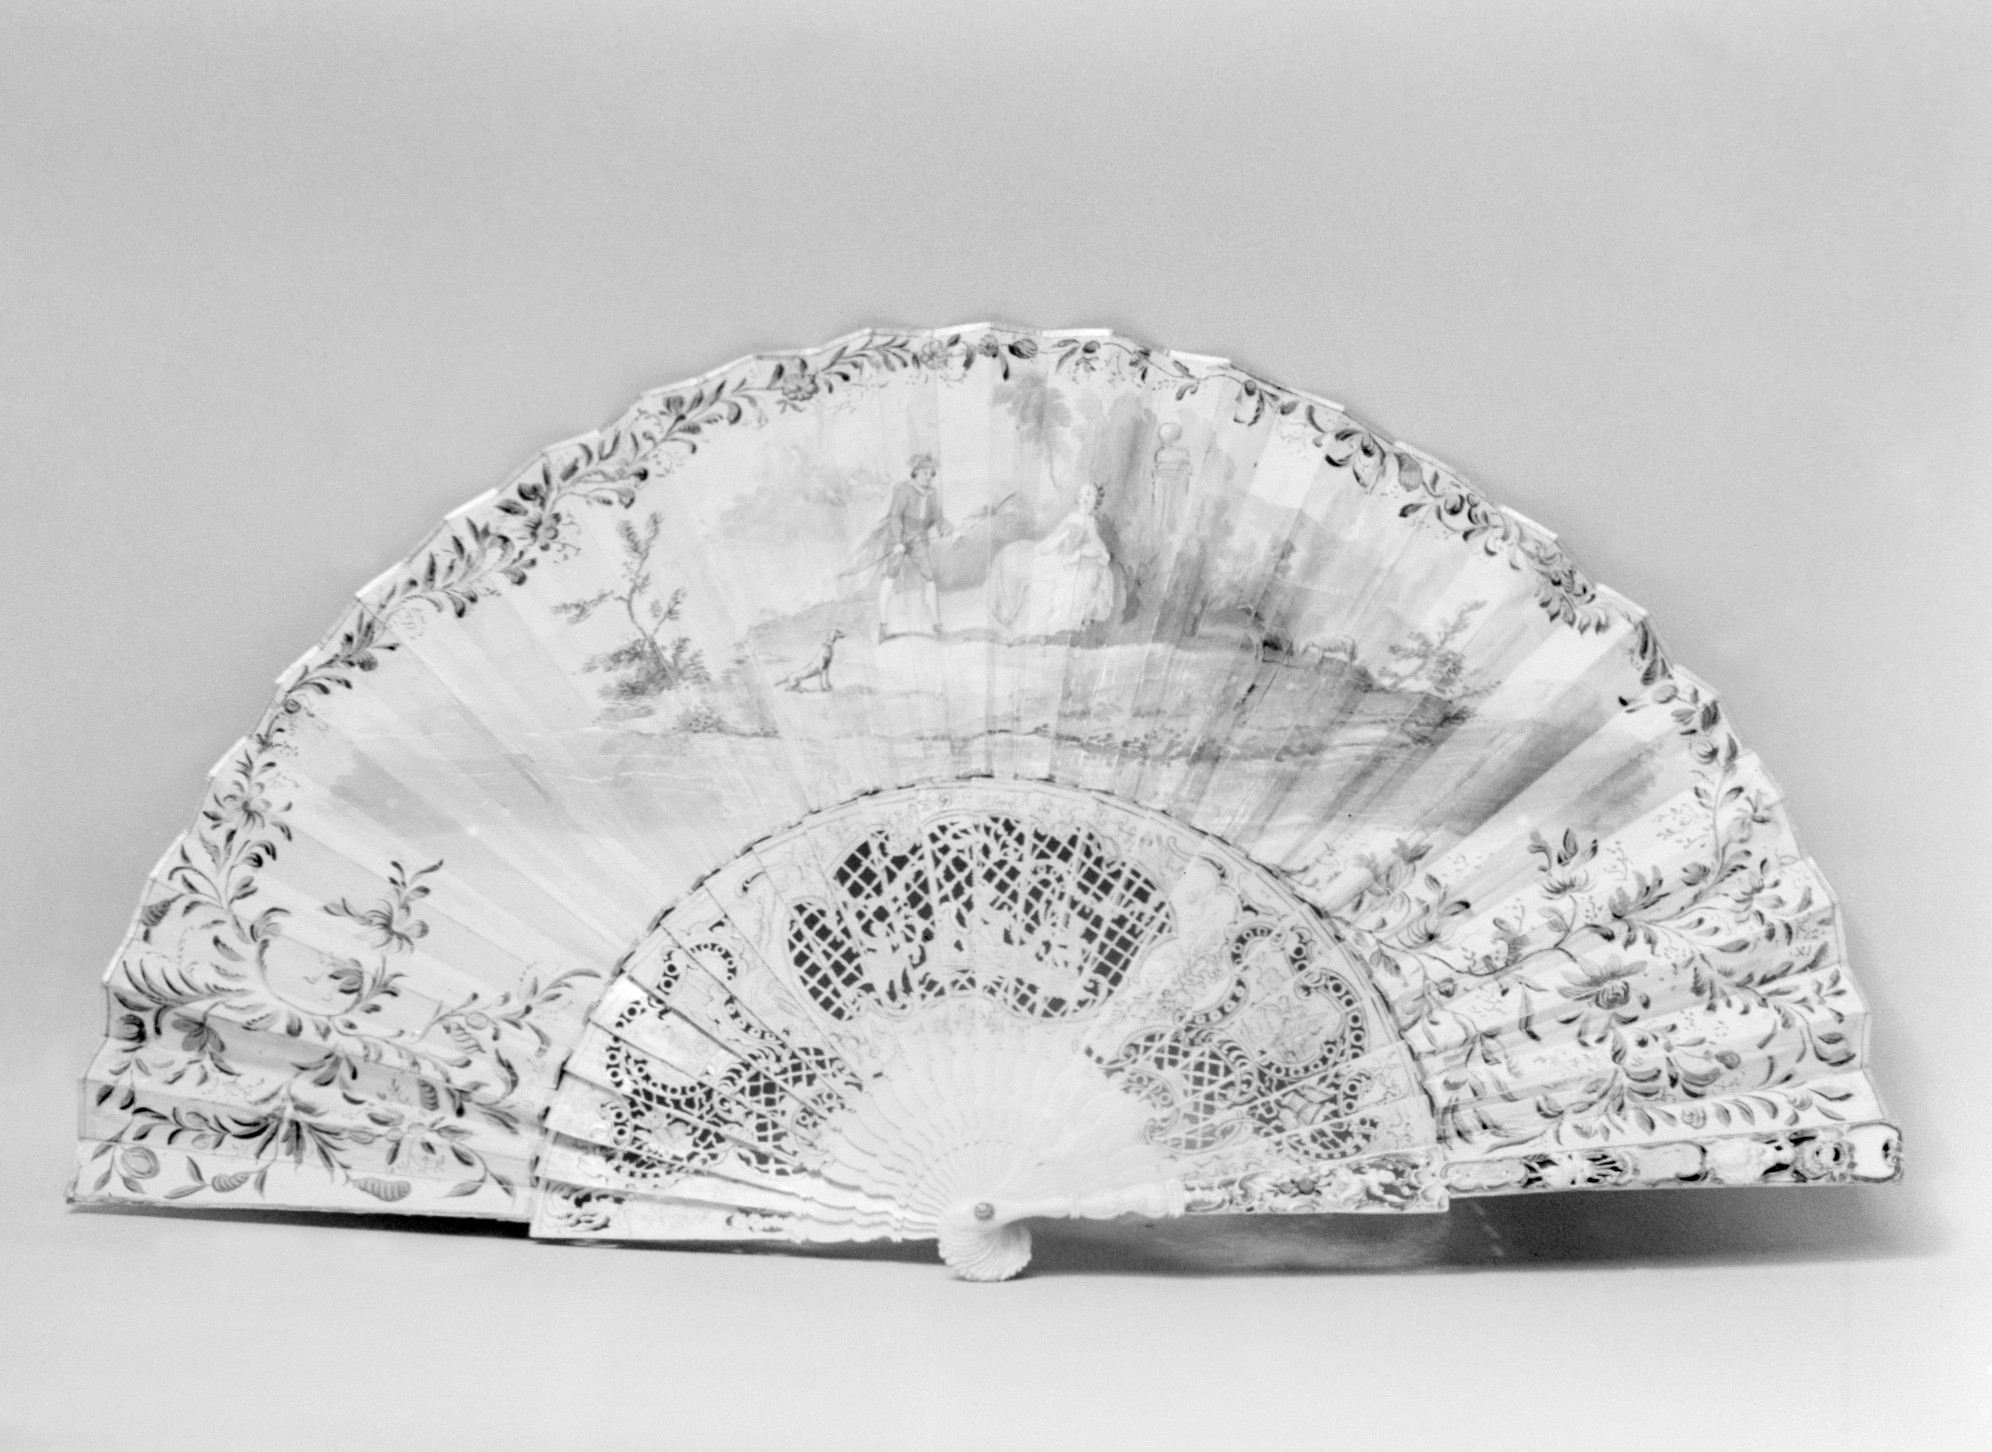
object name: fan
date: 1701-1800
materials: diamond, ivory, paper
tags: men,women